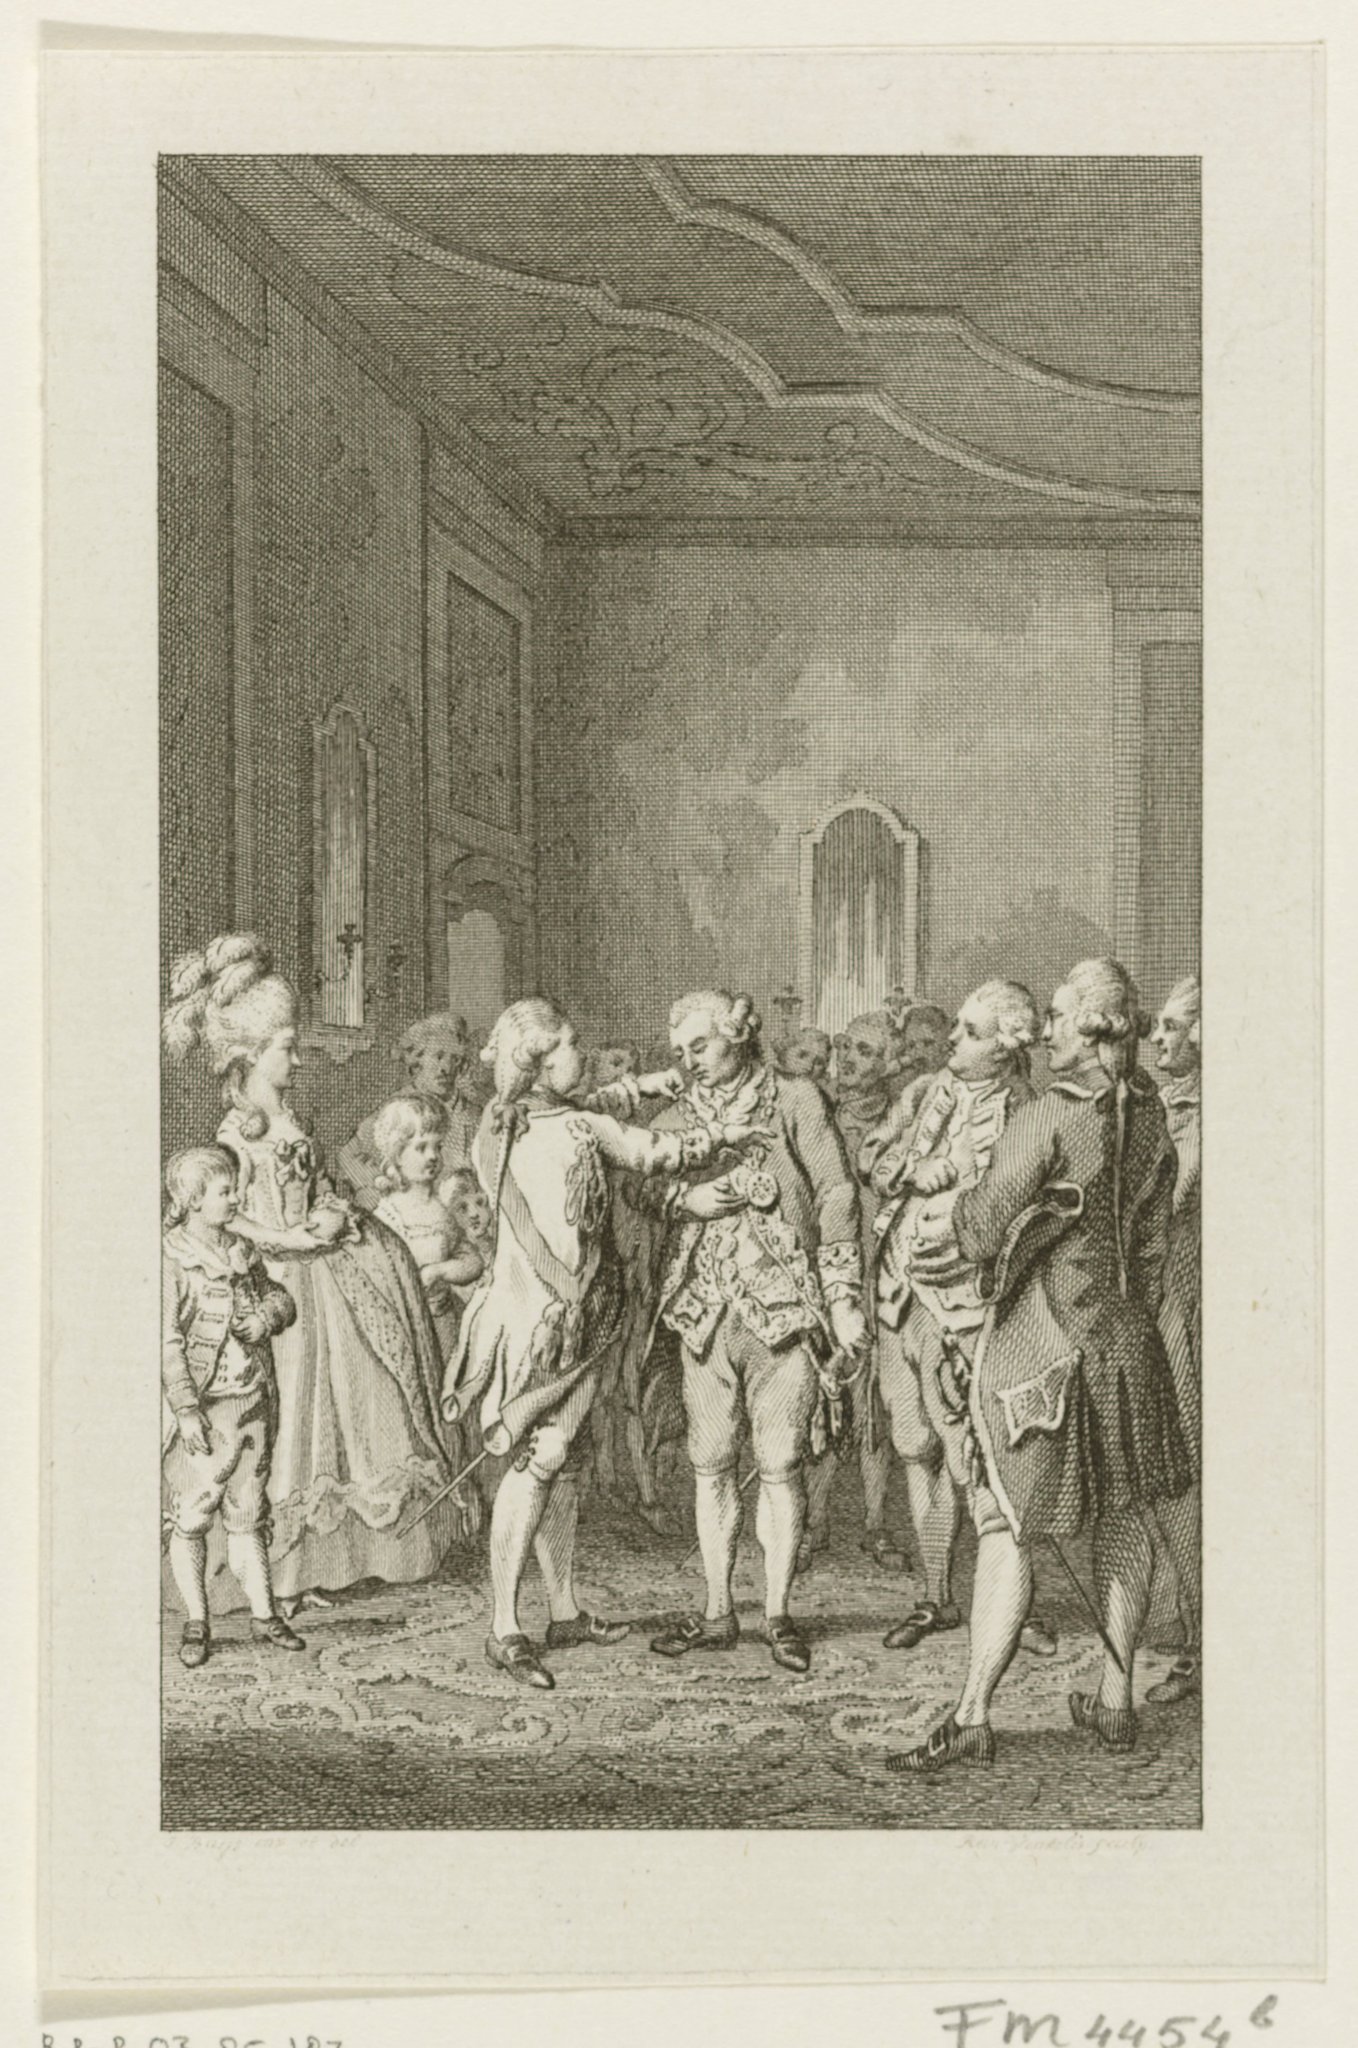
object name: print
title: Willem V vereert de helden van de zeeslag bij Doggersbank, 1781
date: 1788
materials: paper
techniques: engraving, etching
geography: northern netherlands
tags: william v (prince of orange), johan arnold zoutman, medals and other marks of military honour (+ sailing-ships)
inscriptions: collector's mark: Lugt 2228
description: Gebruikt als illustratie in: P.A. Loosjes. Vaderlandsche historie, vervattende de geschiedenissen, der Vereenigde Nederlanden (...). Ten onmiddelyken vervolge van Wagenaar's Vaderlandsche historie. Dl. 3. Amsterdam: J. Allart, 1788.